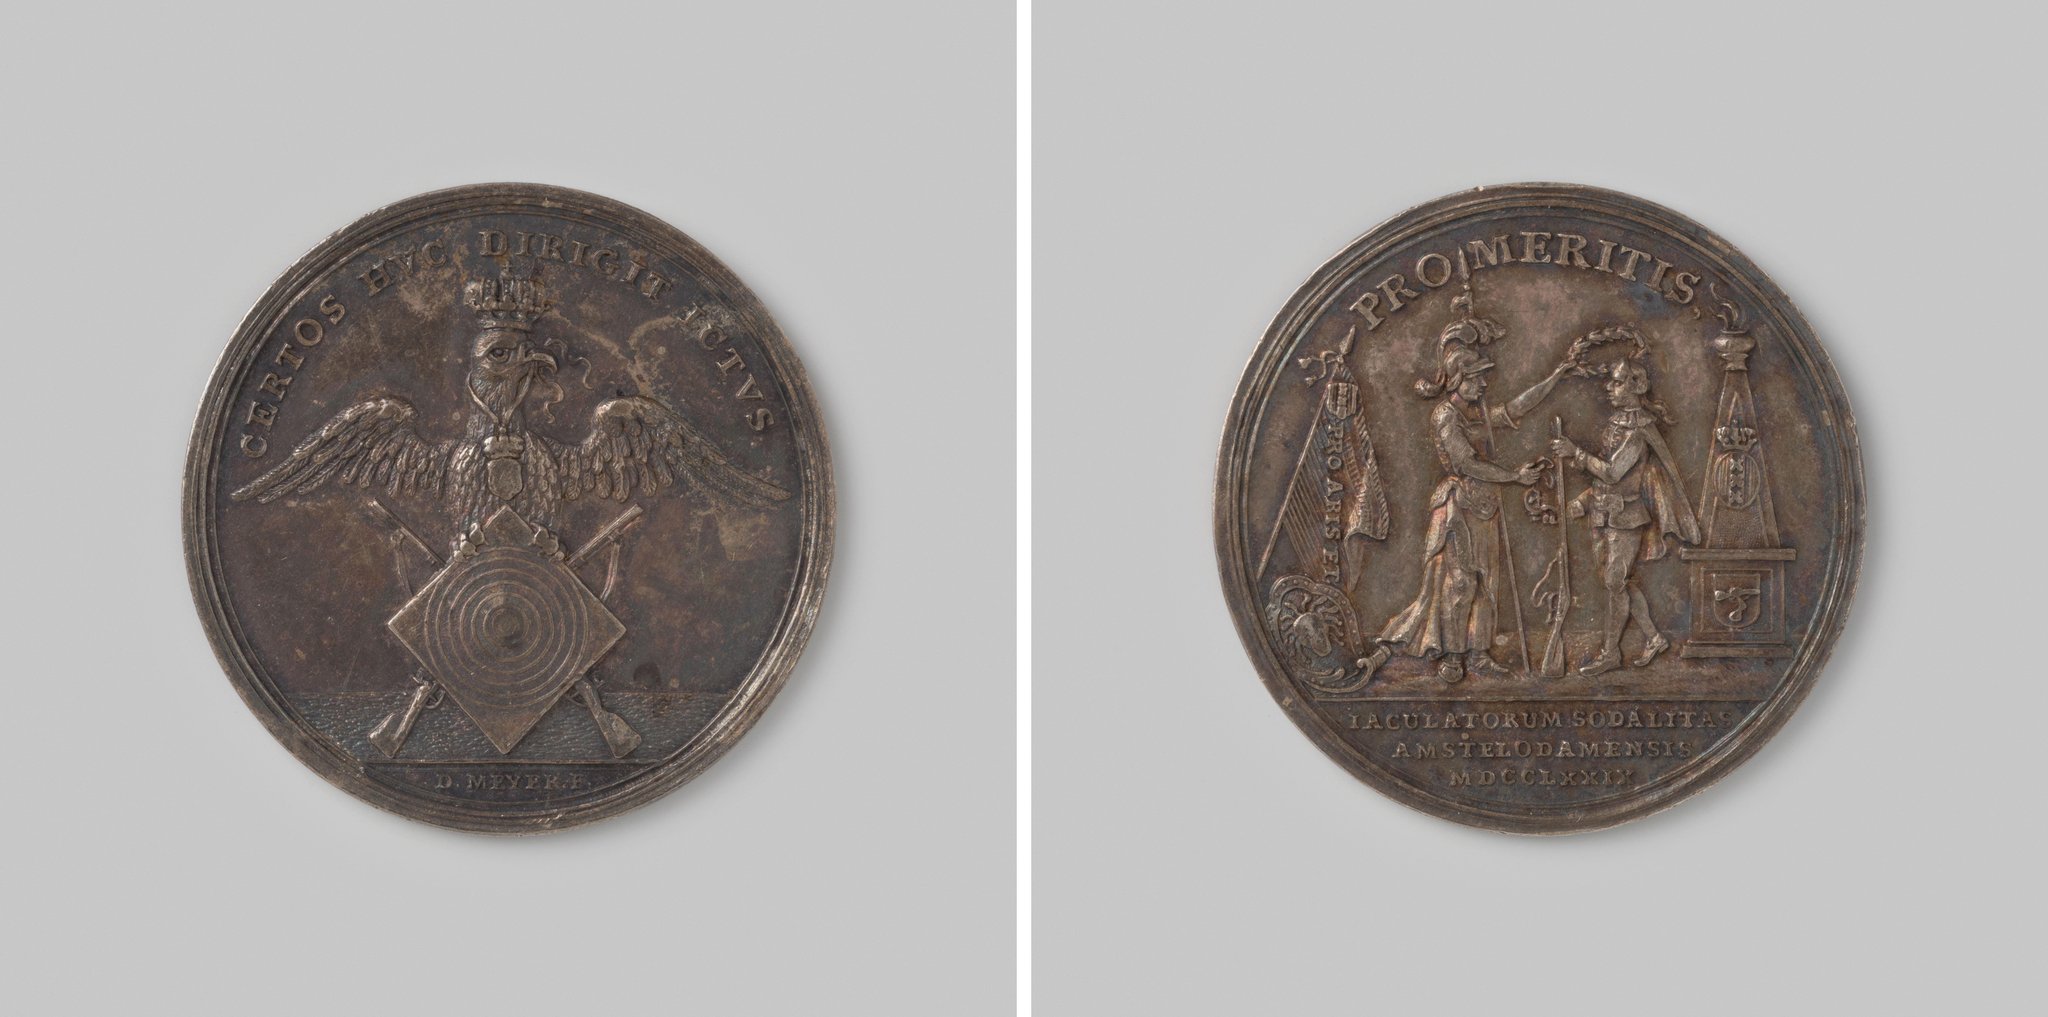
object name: history medal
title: Prijspenning van het schuttersgezelschap te Amsterdam (1779)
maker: hendrik de meijer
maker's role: die cutter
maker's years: 1766-1789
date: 1779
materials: silver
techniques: pressing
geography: amsterdam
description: Zilveren penning, op de voorzijde een gekroonde adelaar met voor zich een vierkante schietroos, met omschrift, op de keerzijde Pallas die een schutter lauwert en een medaille met adelaar overhandigt, met links een vaandel en een barok medusaschild en rechts een monument waartegen een Amsterdams wapenschild, met omschrift en afsnedetekst.